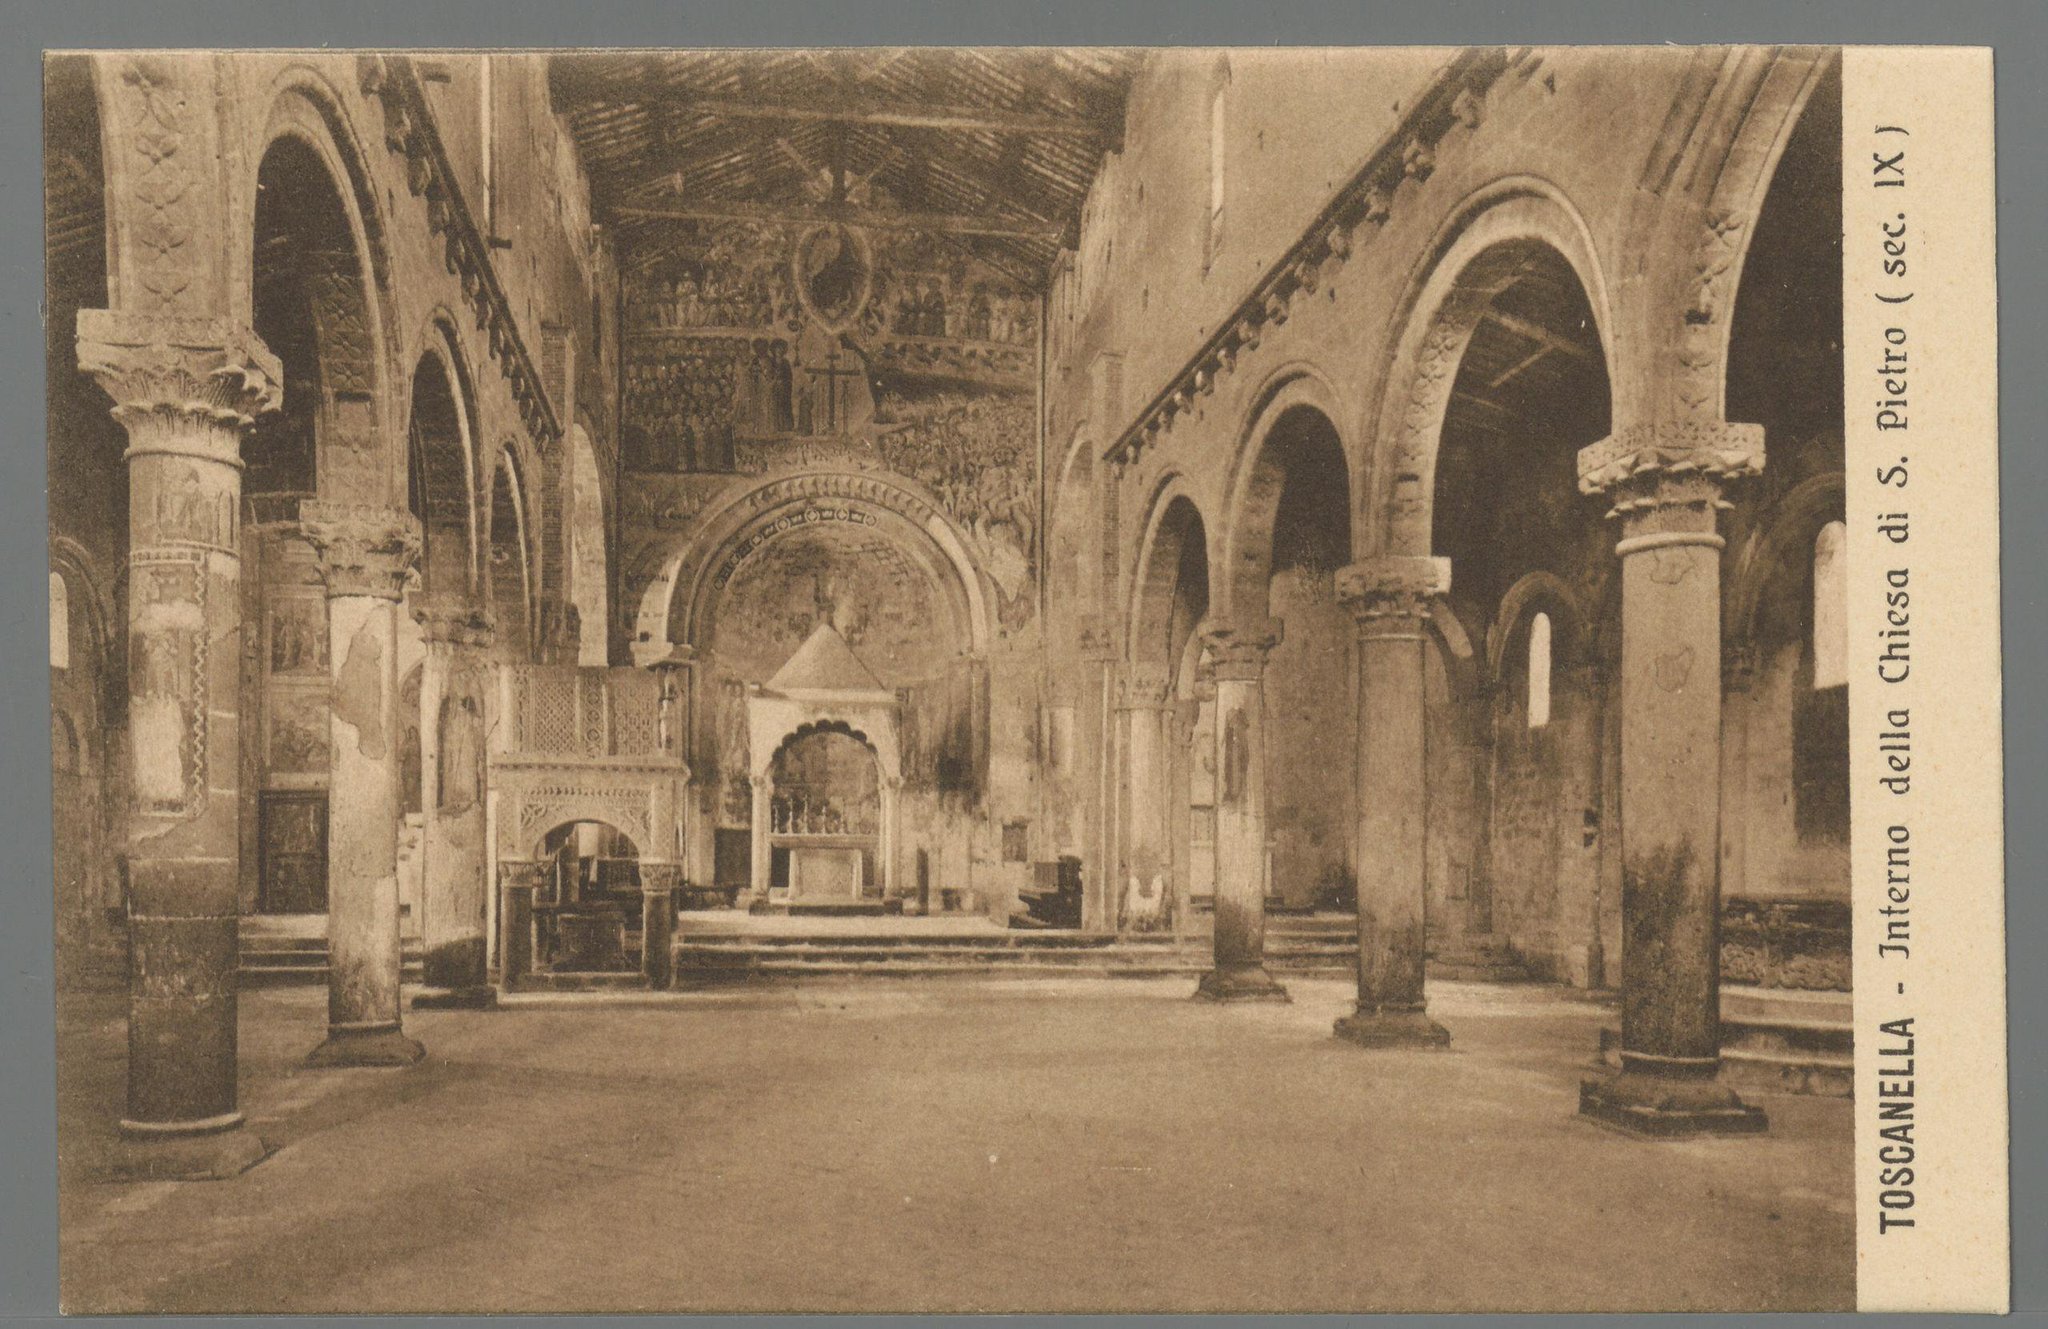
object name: photomechanical print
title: Toscanella. Interno della Chiesa di S. Pietro (sec. IX)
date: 1906-1920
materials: cardboard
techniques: photograph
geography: tuscania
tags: interior of church